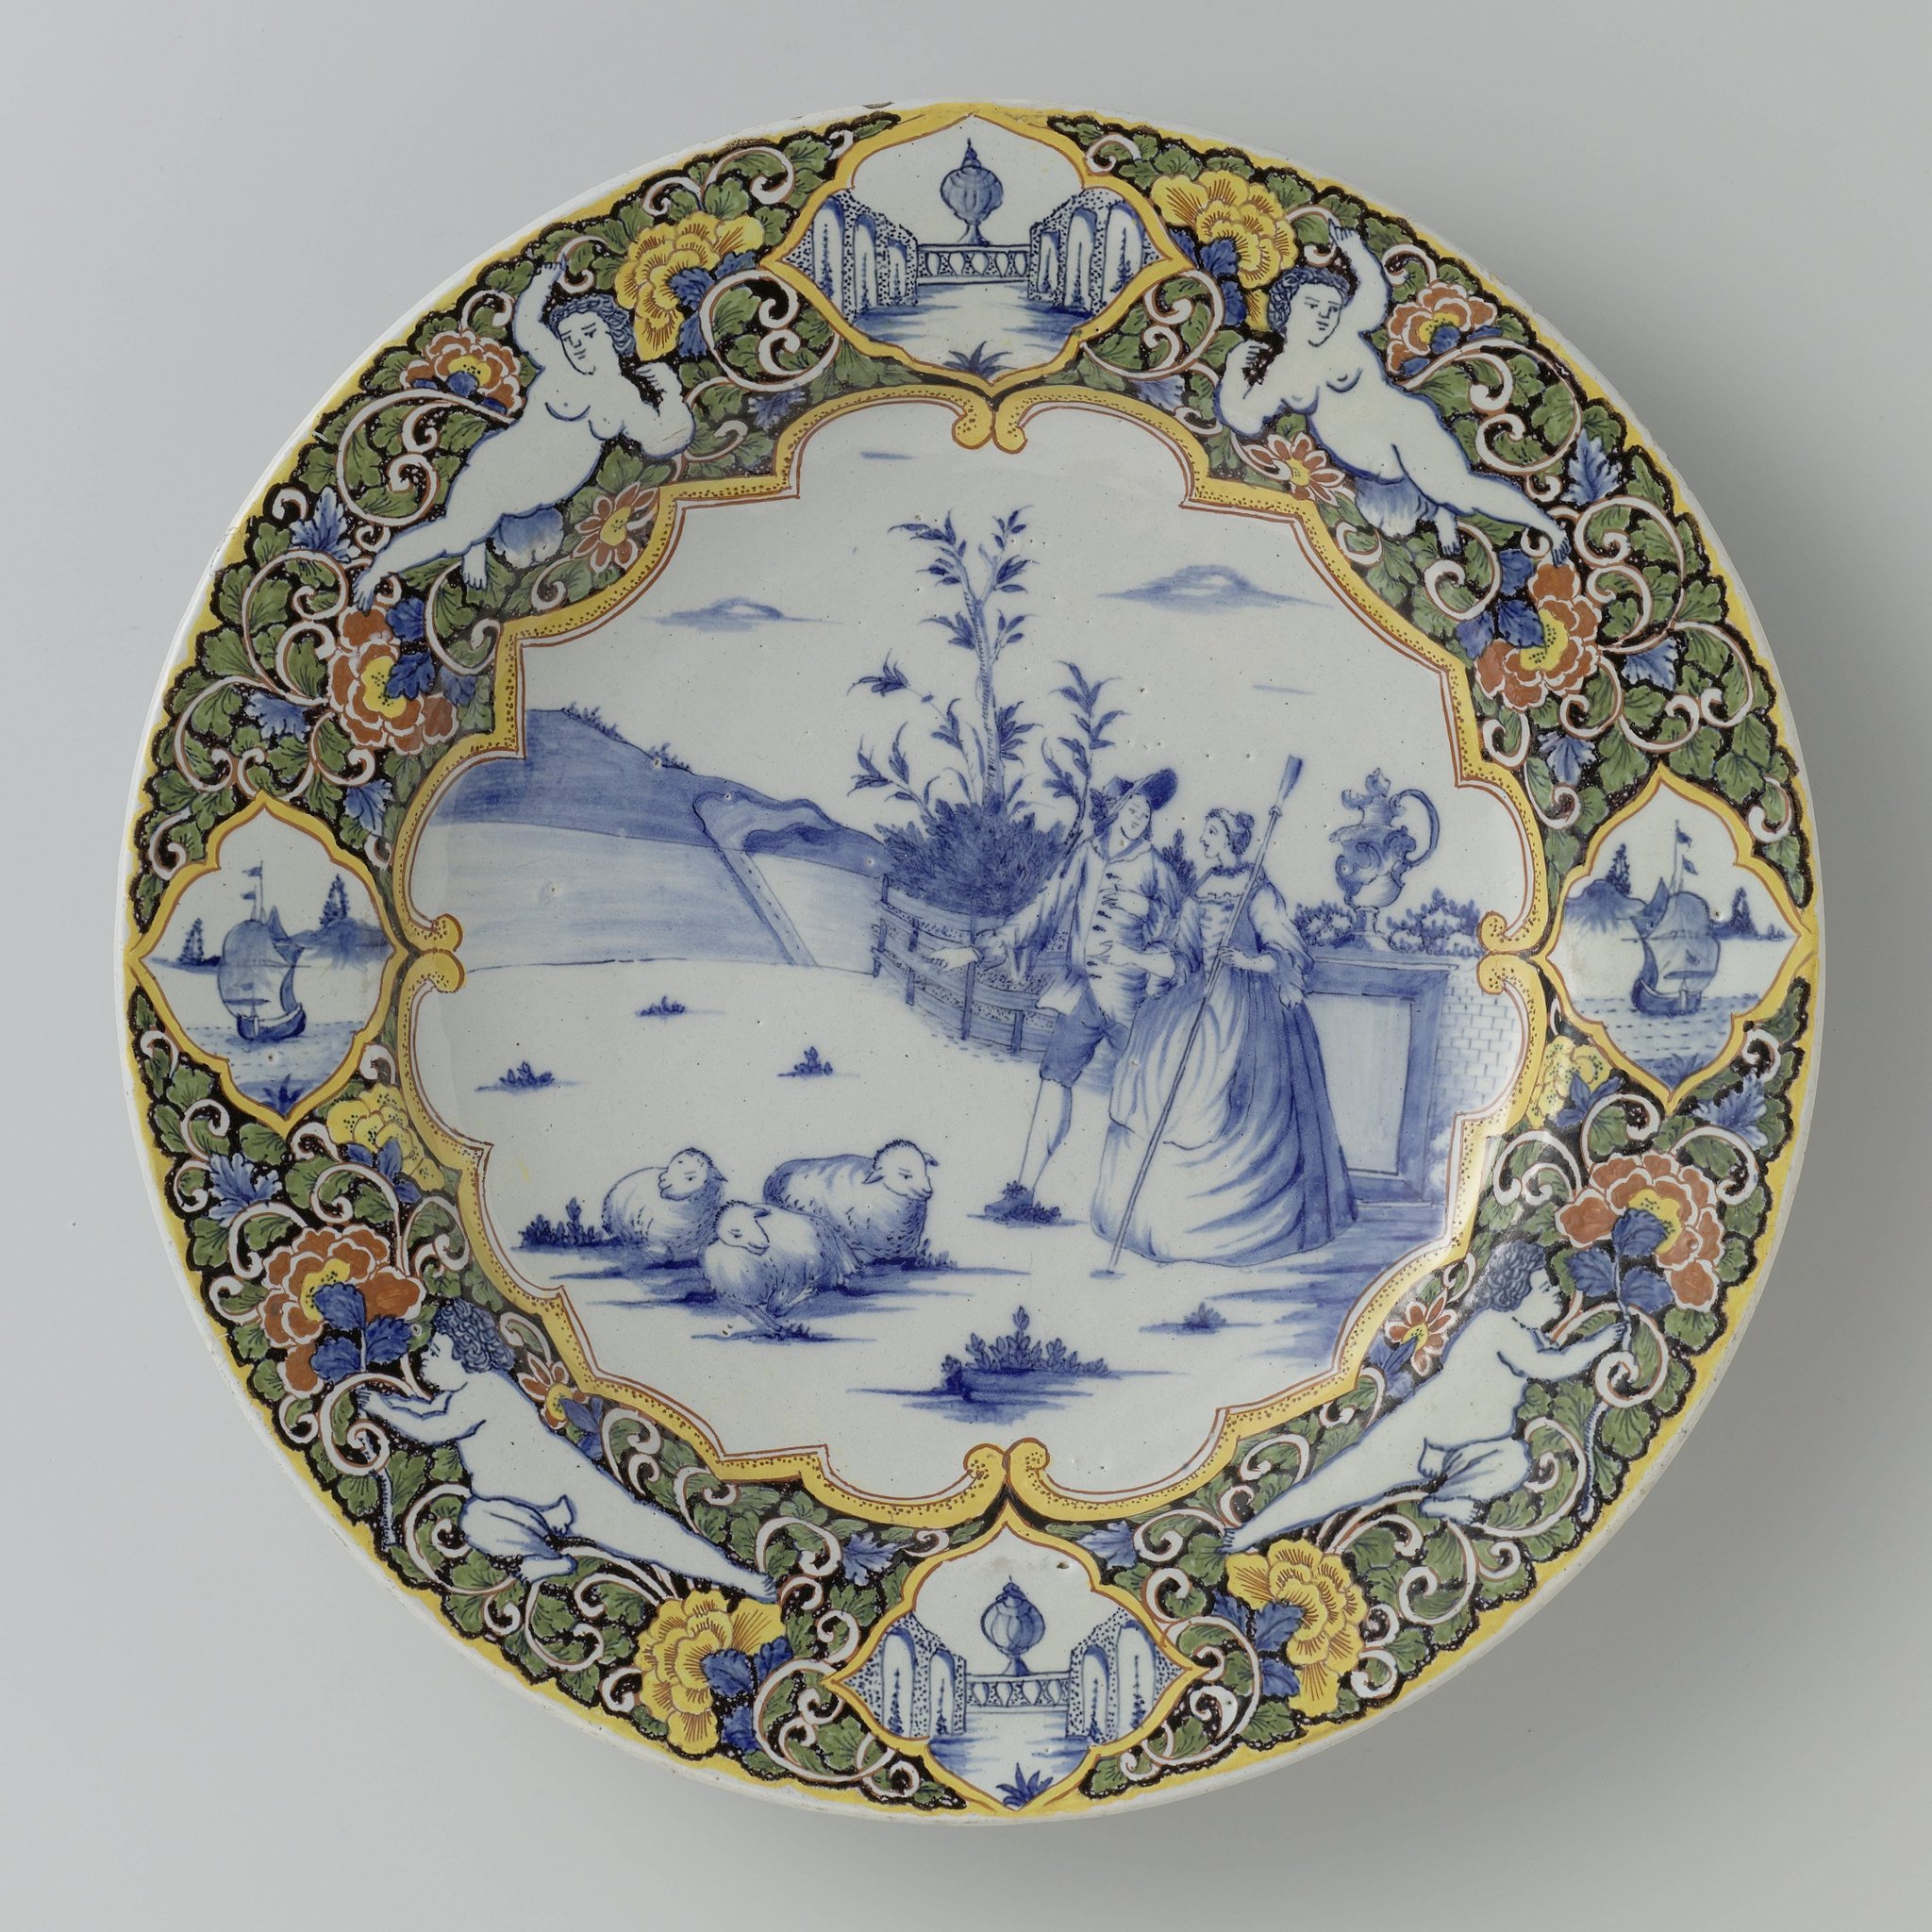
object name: platter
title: Schotel met op het plat in blauw een herdersscène binnen Louis XIV rand. Veelkleurige randversiering op zwarte grond met putti en vier medaillons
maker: Anonymous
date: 1740-1775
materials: faience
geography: delft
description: Schotel van faïence, met op het plat in blauw een herdersscène binnen Louis XIV rand. Veelkleurige randversiering op zwarte grond met putti en vier medaillons.